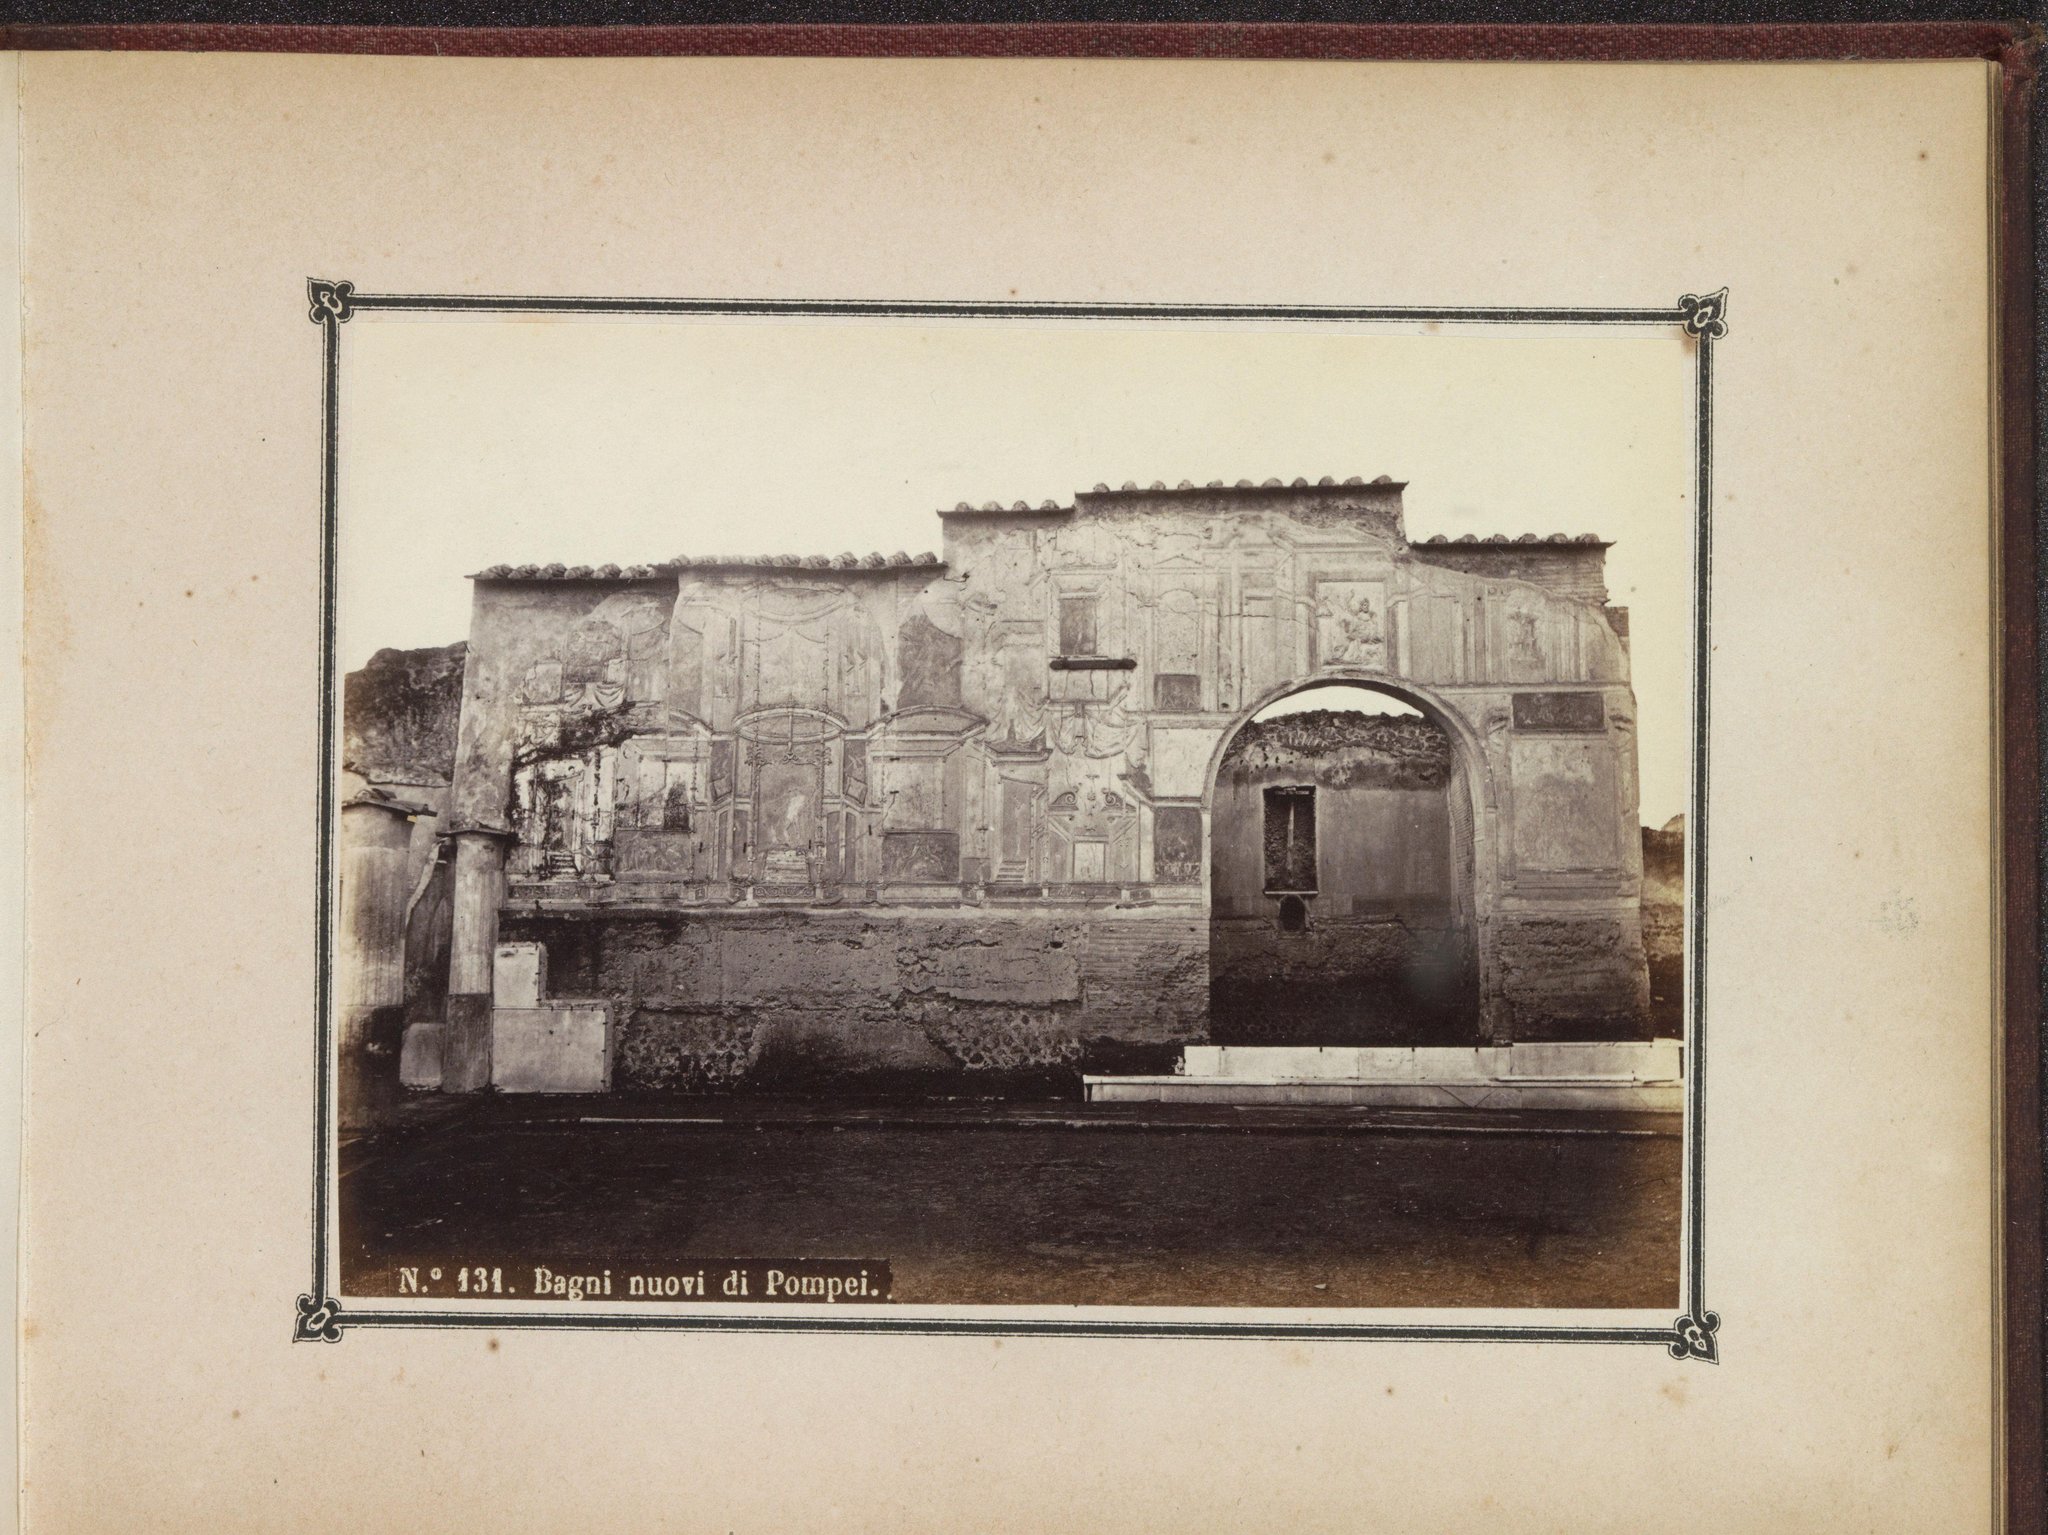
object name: album leaf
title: Bagni nuovi di Pompei.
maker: roberto rive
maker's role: fotograaf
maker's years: 1825-1868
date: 1860-1900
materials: paper, photographic support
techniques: albumen print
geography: pompeii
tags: public baths, excavation ~ archaeology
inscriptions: number: ‘131’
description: Onderdeel van Fotoalbum met opnames van opgravingen in Pompeï door Roberto Rive.